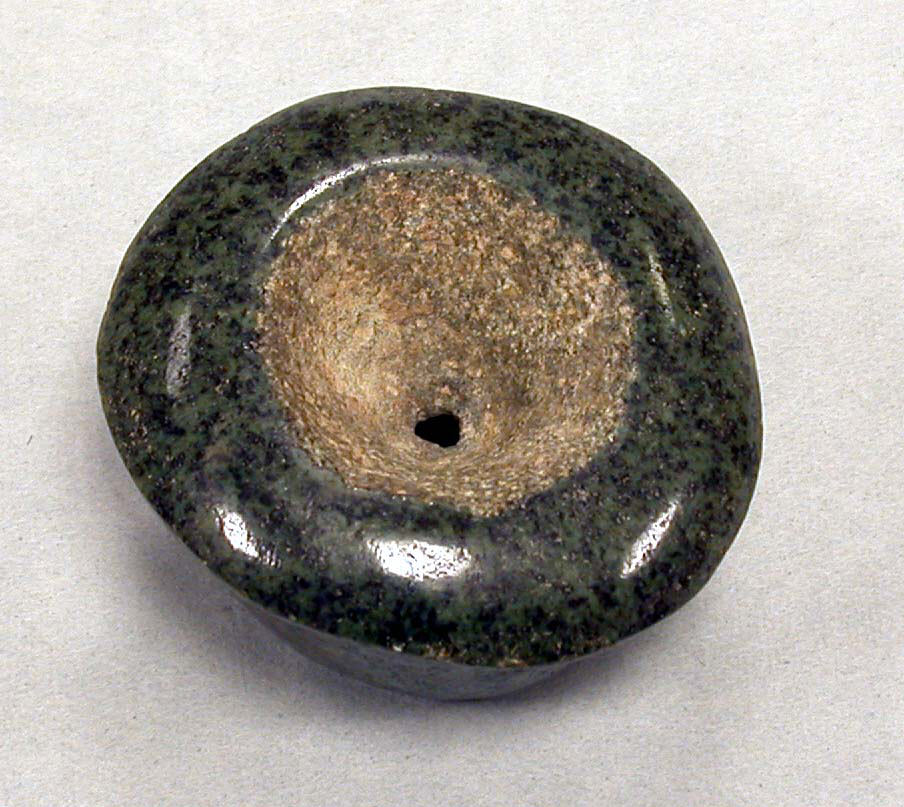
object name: weight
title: Stone Weight or Bead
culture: mexican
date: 1501-1600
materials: stone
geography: mexico